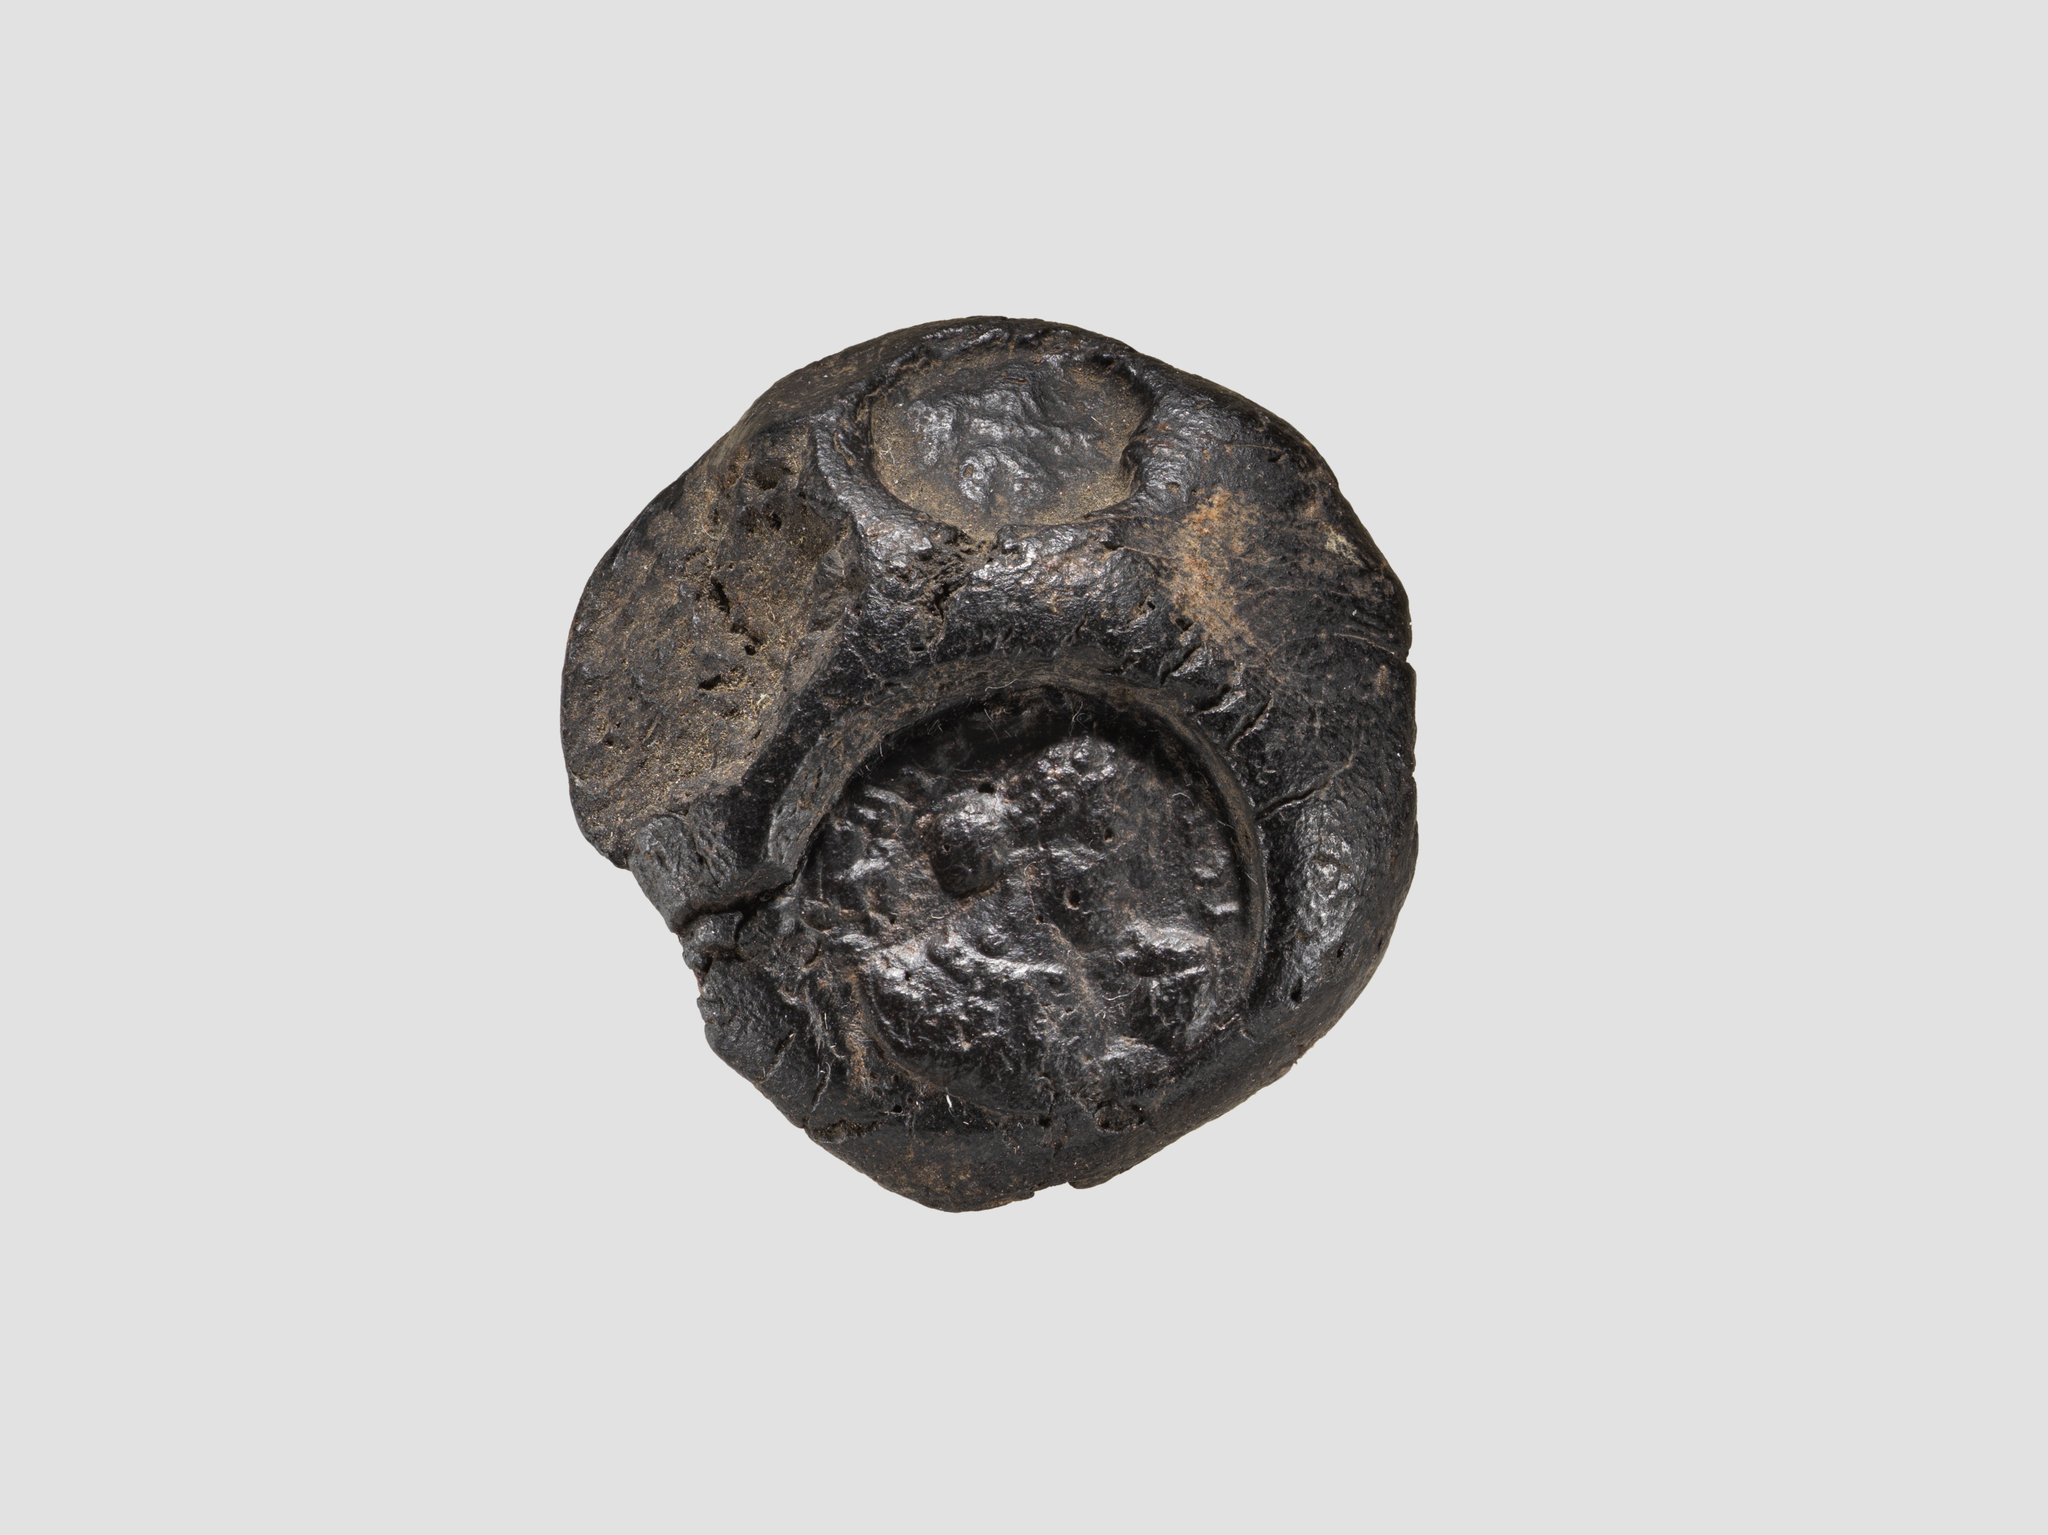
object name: sealing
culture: sasanian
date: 601-700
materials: clay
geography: iran